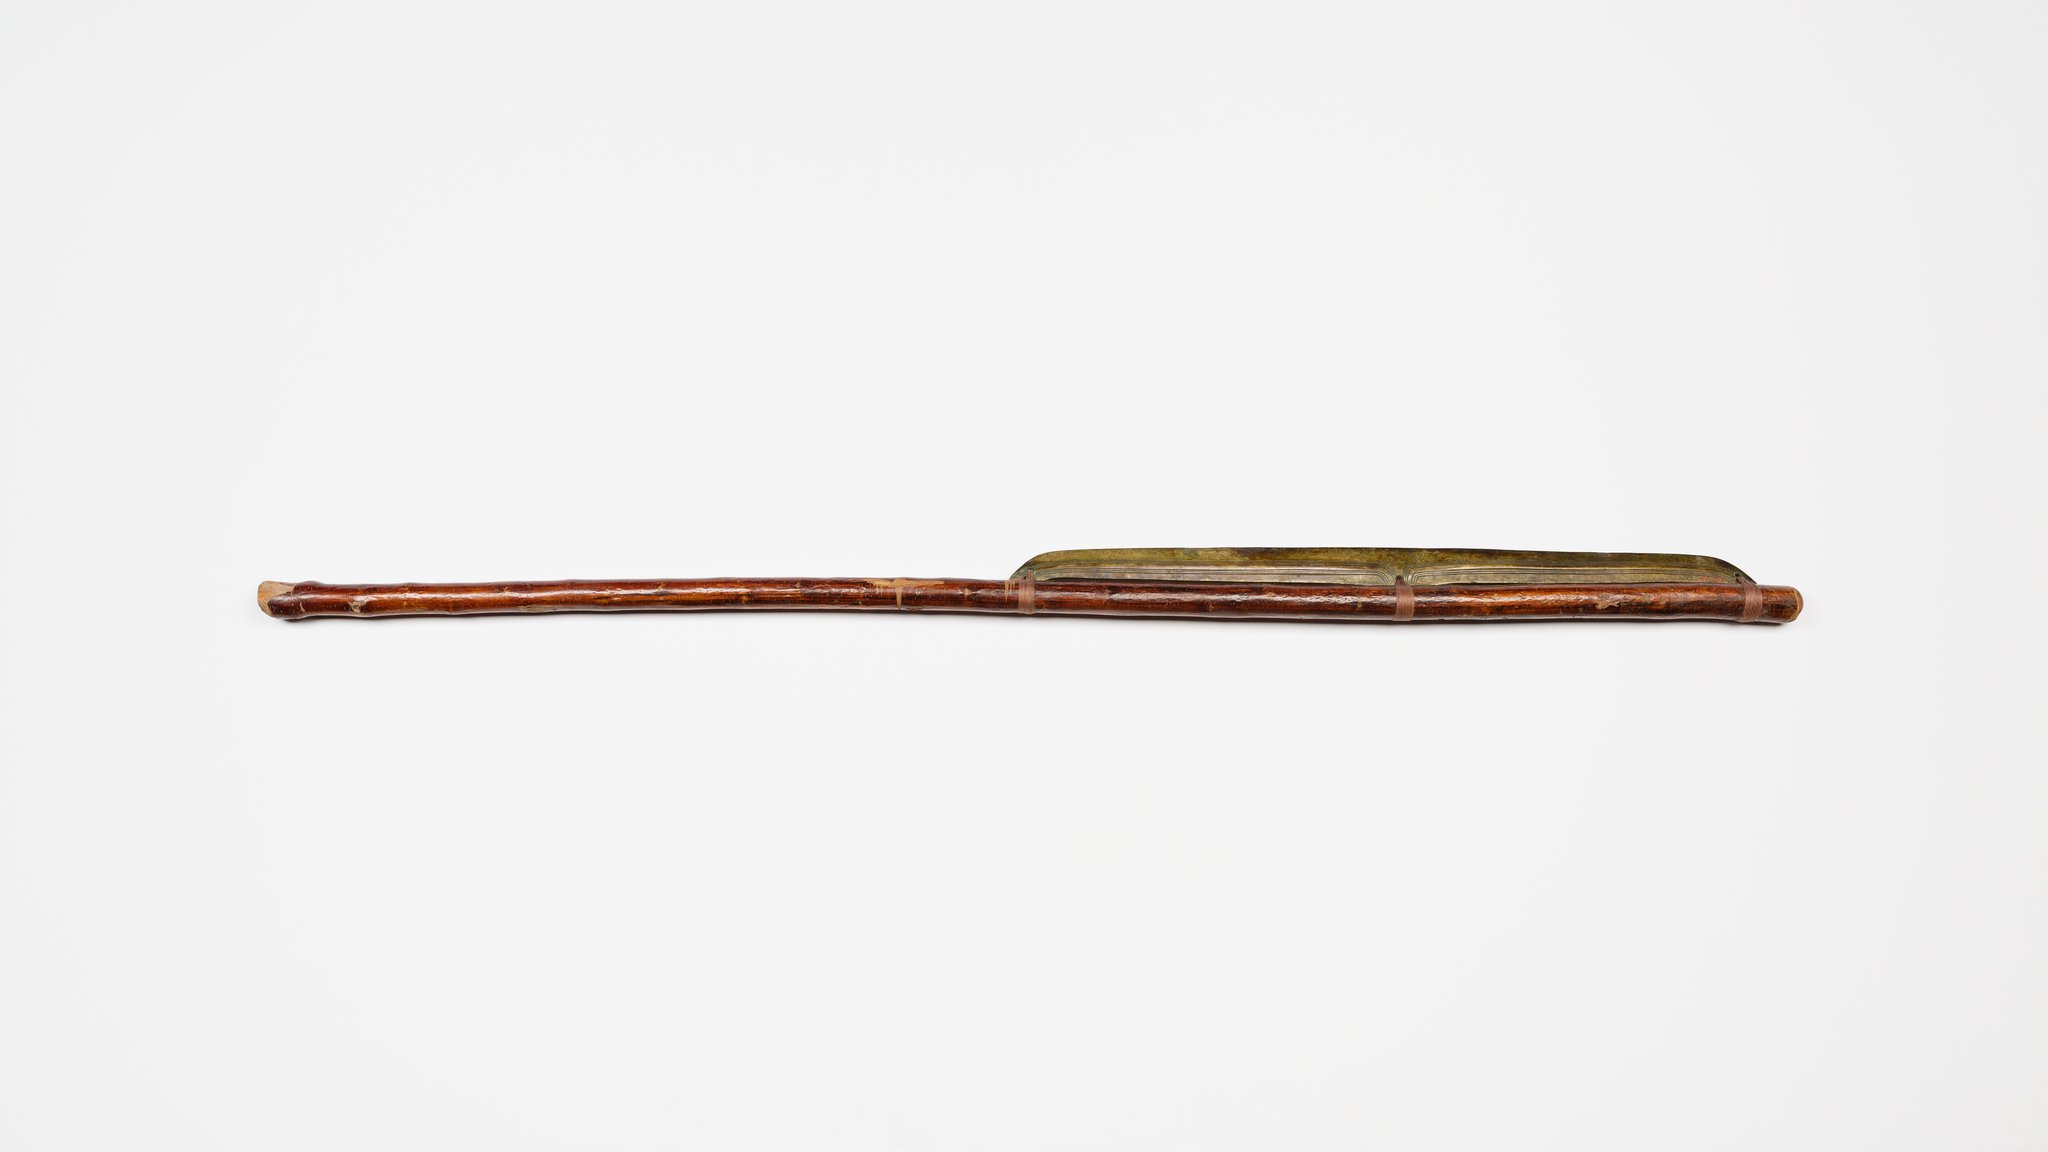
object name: long bladed axe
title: Long-bladed axe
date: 1981-1550 BCE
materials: copper, wood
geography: middle egypt